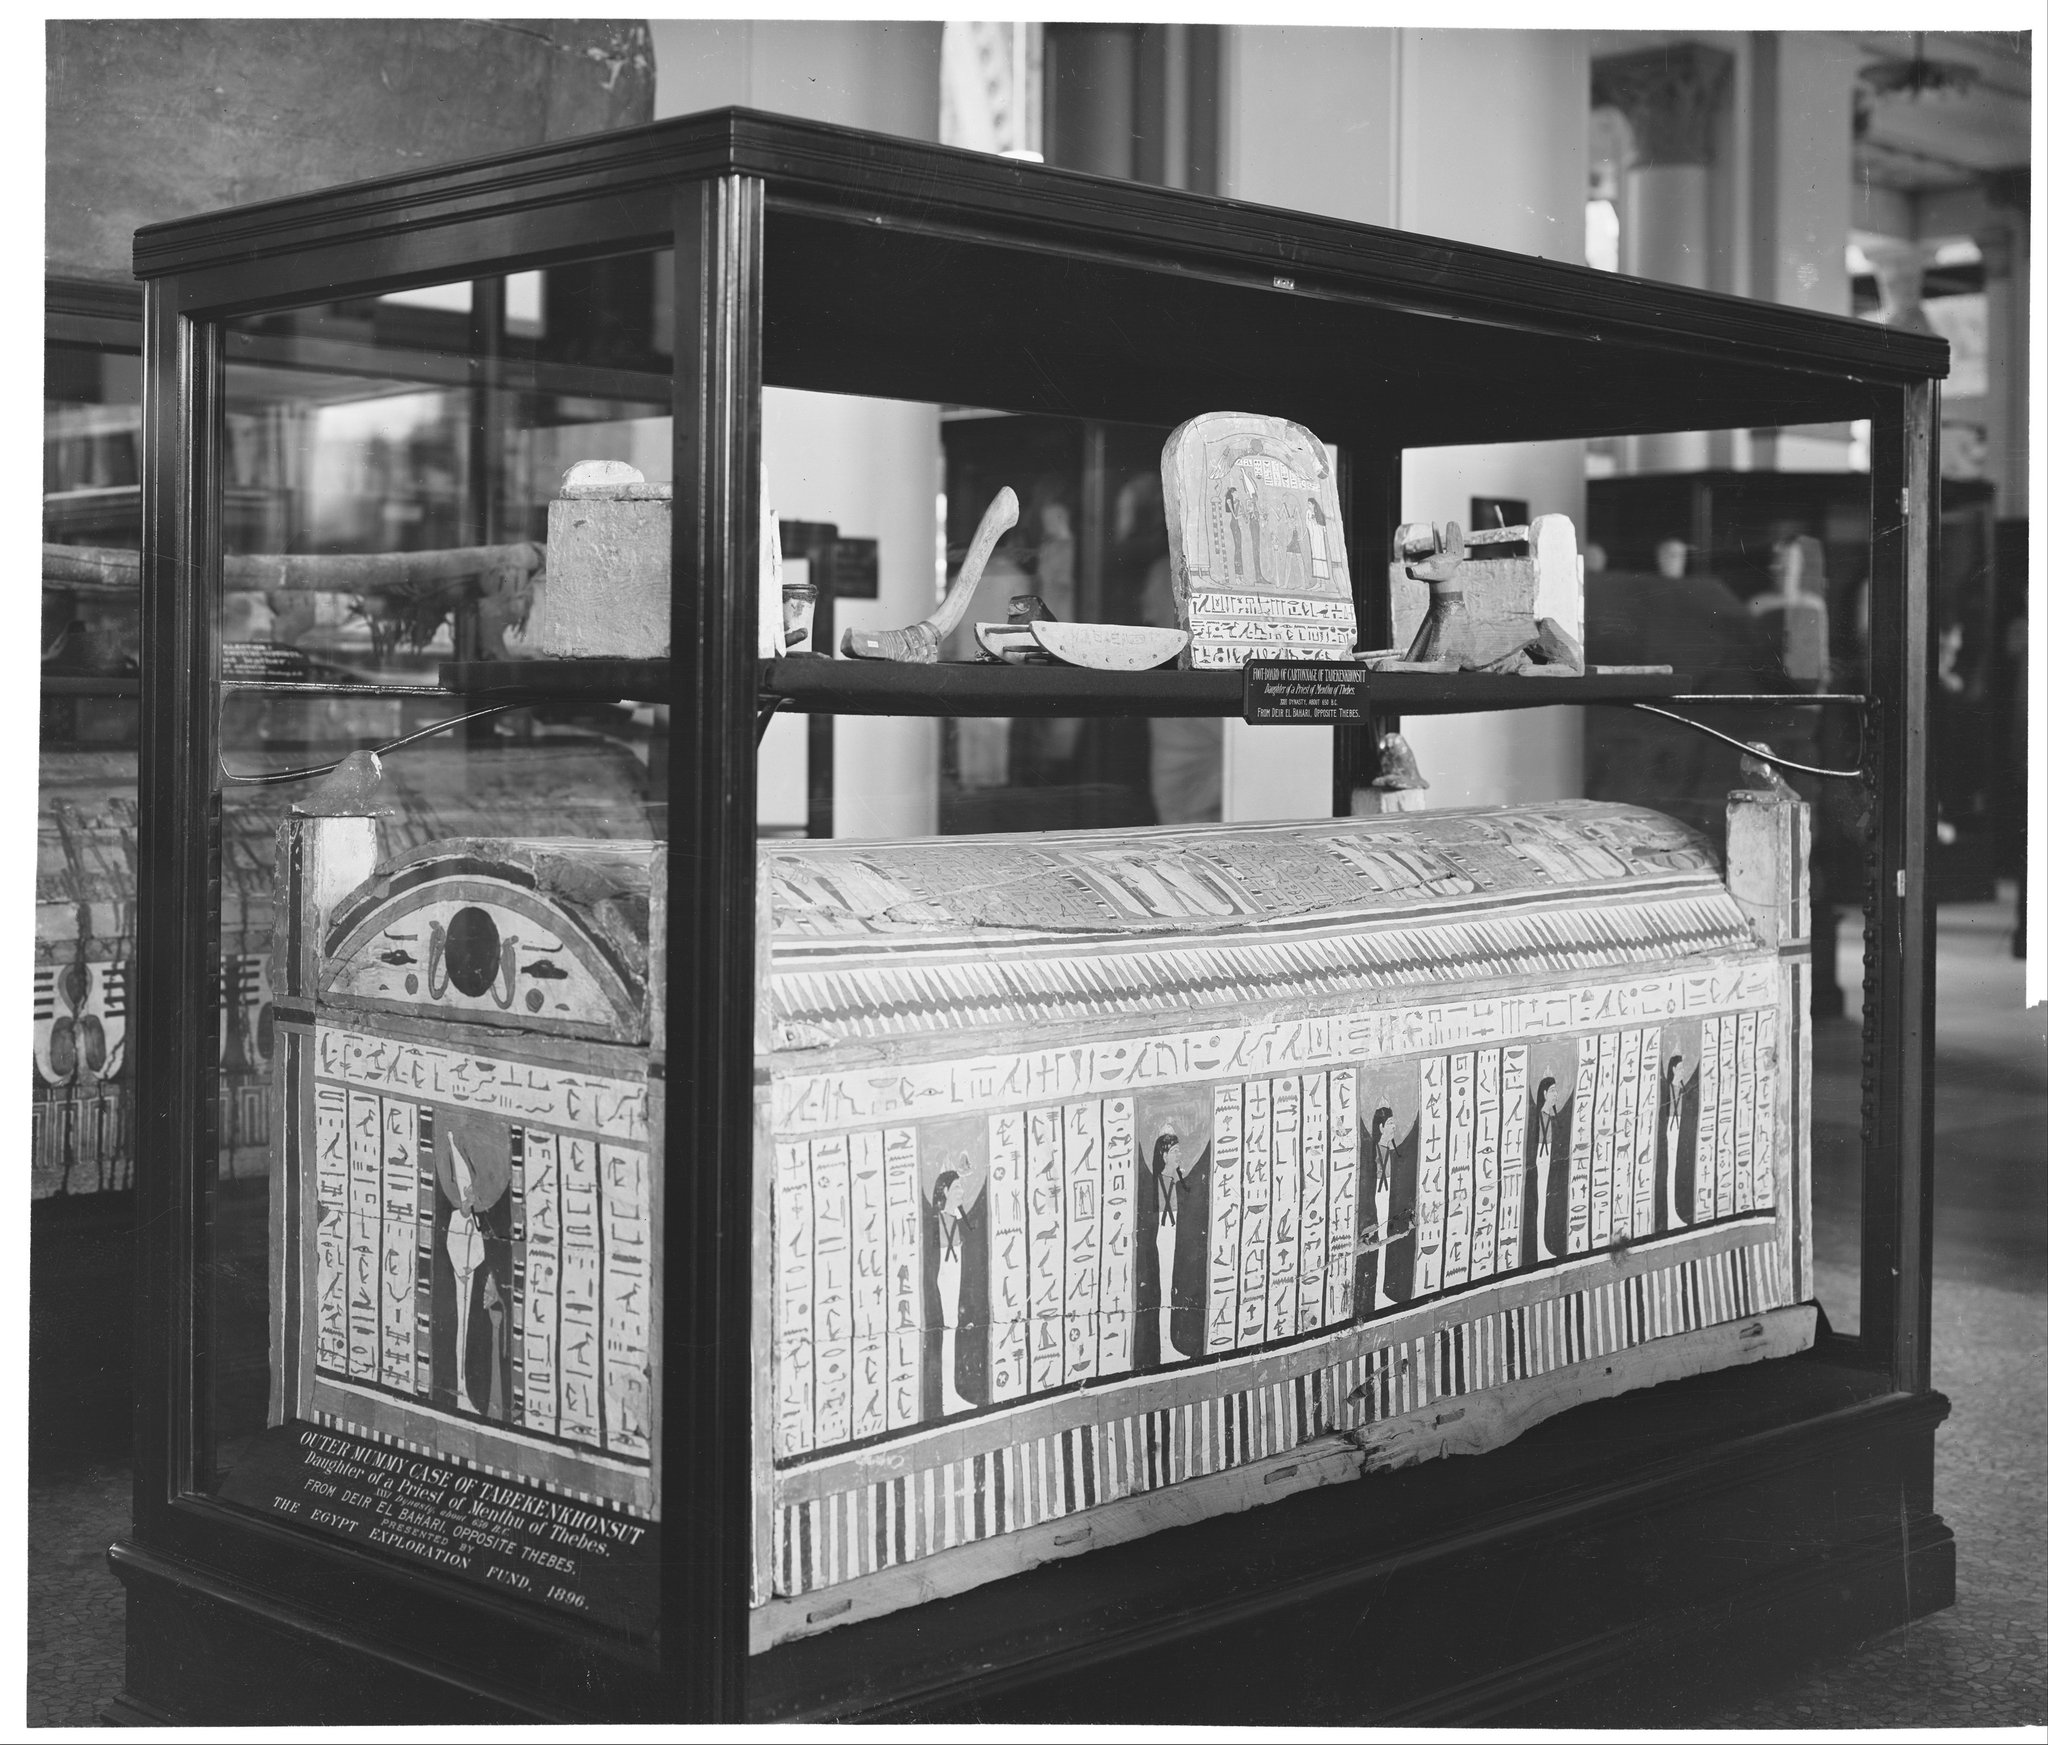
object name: coffin, tabakenkhonsu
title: Outer Coffin of Tabakenkhonsu: Jackal from Top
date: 680-670 BCE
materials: gesso, paint, plaster, wood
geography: egypt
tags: hieroglyphs,coffins